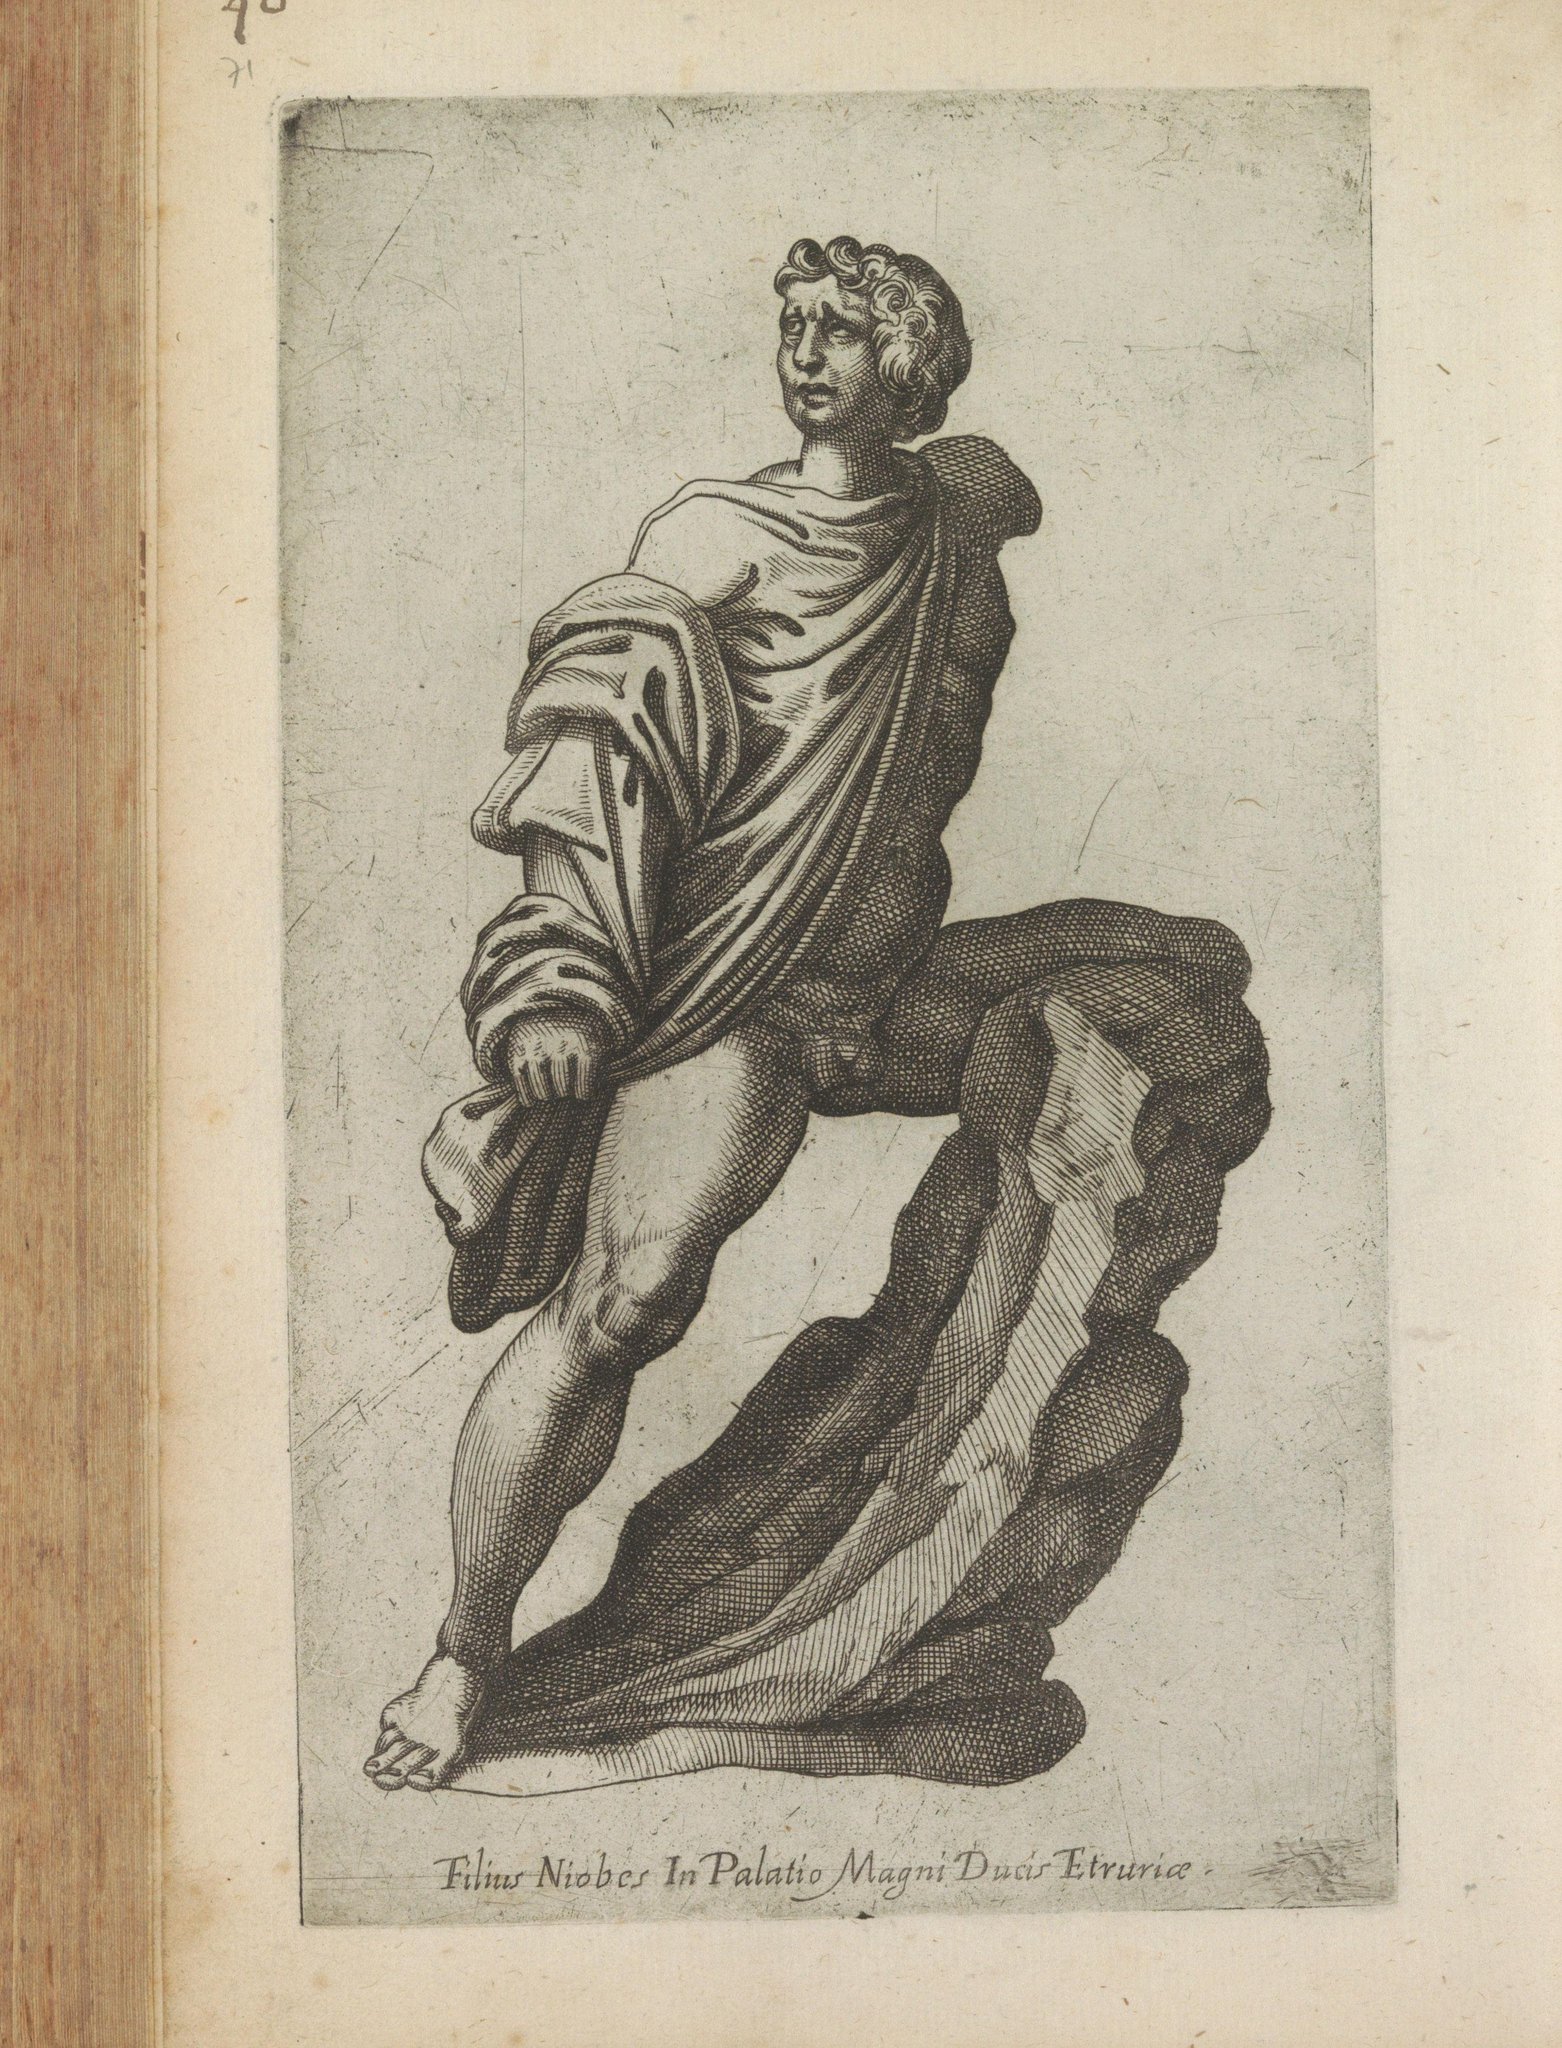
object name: album leaf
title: Antiquarum statuarum urbis Romae quae in publicis locis visuntur icones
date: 1584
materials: paper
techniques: engraving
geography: rome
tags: the sons of niobe, who were mounting their horses, die by the darts of apollo, piece of sculpture, reproduction of a piece of sculpture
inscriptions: number: ‘40’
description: Deze prent maakt deel uit van een set van 79 prenten (+ titelprent) met voorstellingen van antieke sculpturen in Rome.